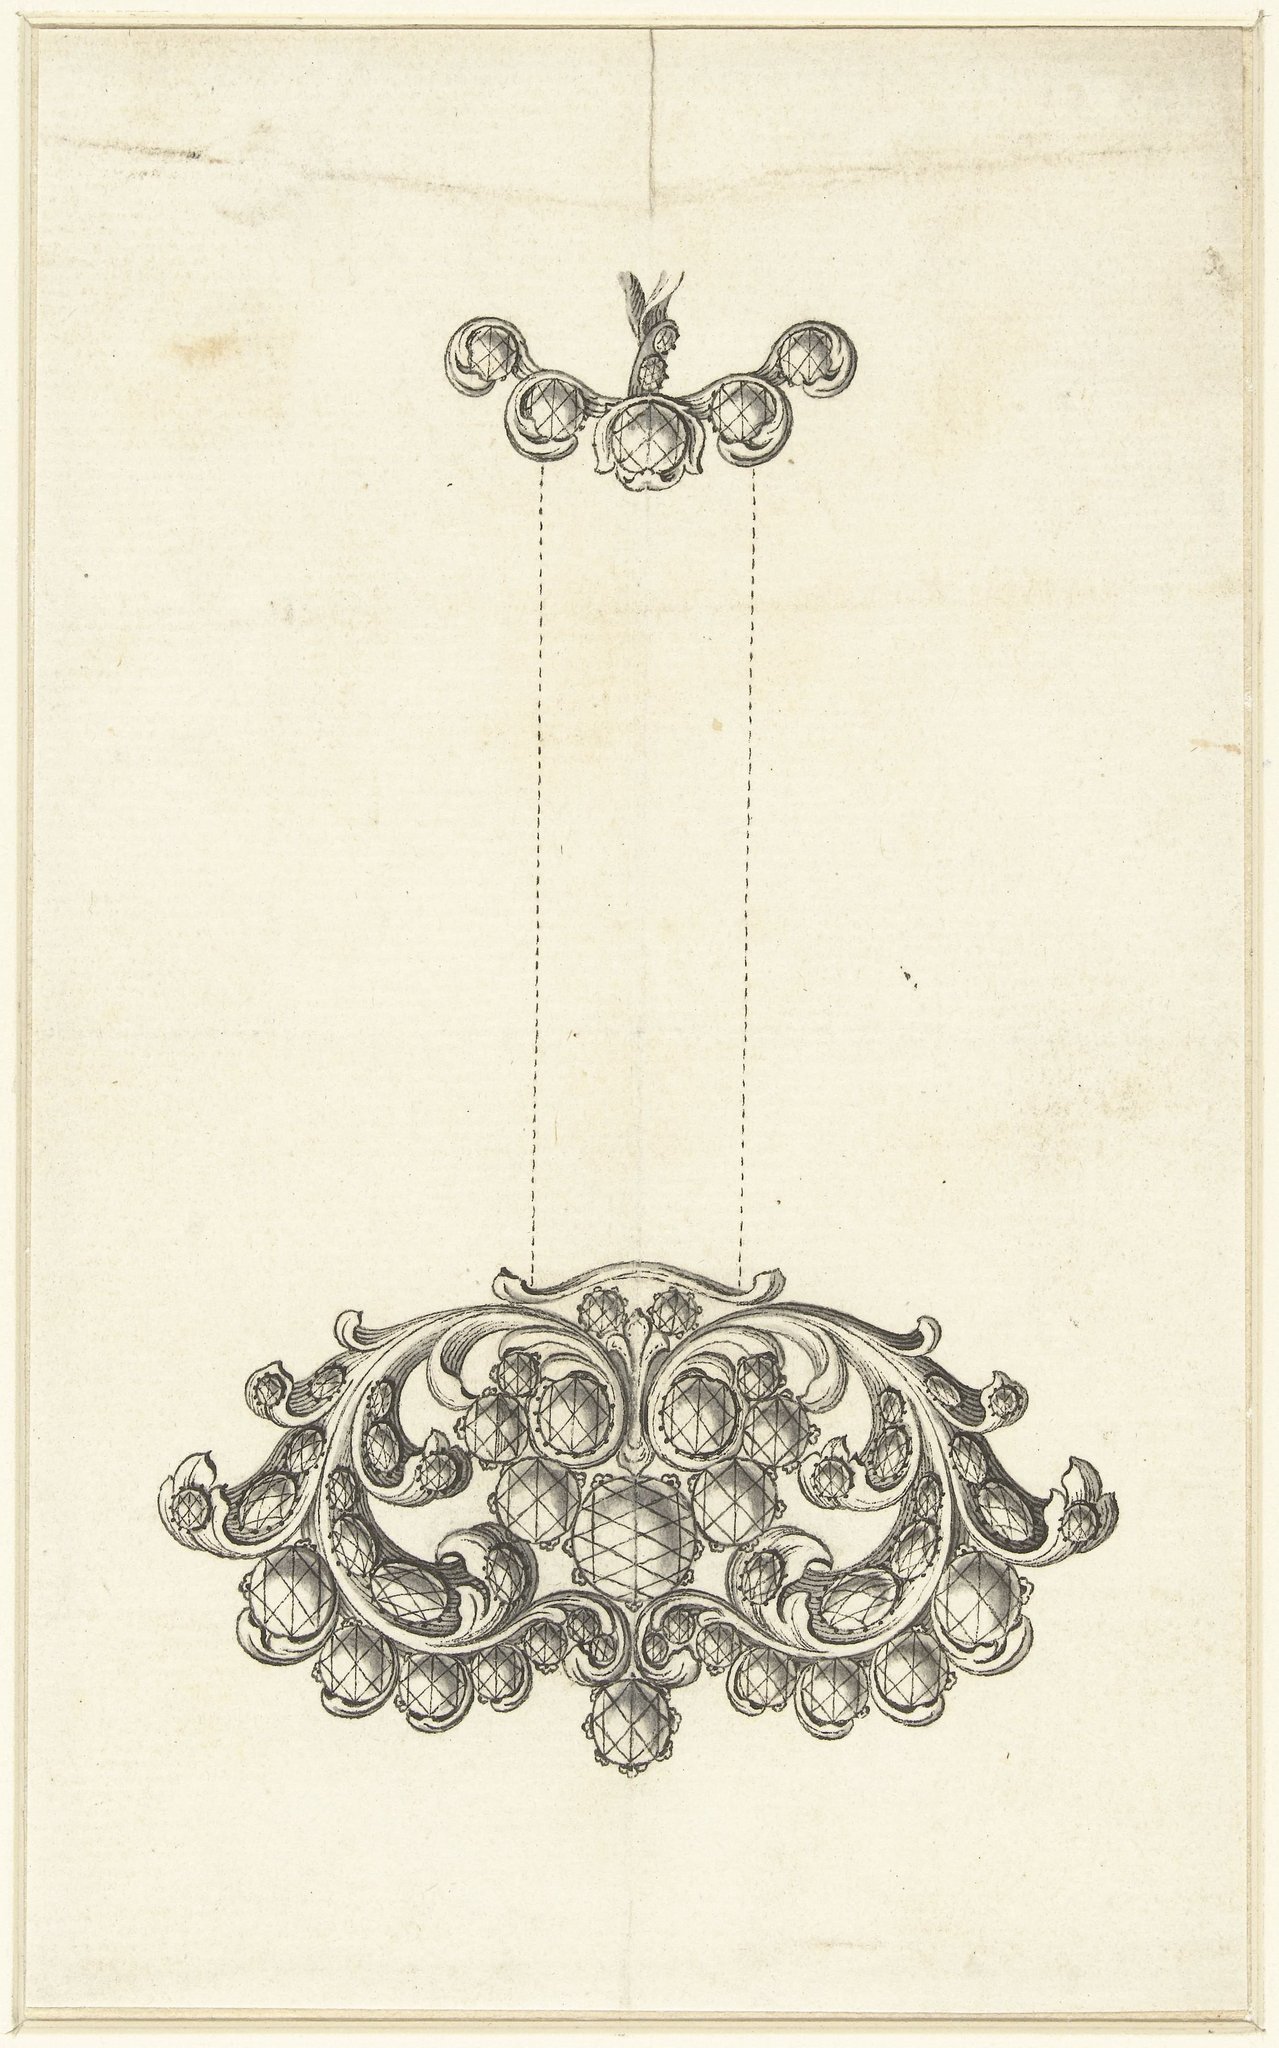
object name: drawing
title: Design for a Breast Ornament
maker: carlo ciampoli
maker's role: draughtsman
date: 1701-1721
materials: ink, paper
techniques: brush, pen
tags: brooch, agraffe, clasp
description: This detailed drawing shows a jewel with rose-cut diamonds that was worn on the breast. At the top is the first part of a necklace that is also set with stones. The jewel’s floral setting in combination with the symmetry and equal size of the precious stones is typical for the beginning of the 18th century.